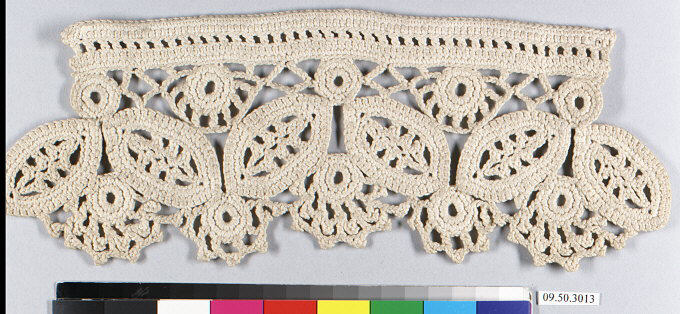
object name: piece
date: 1801-1900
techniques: crochet